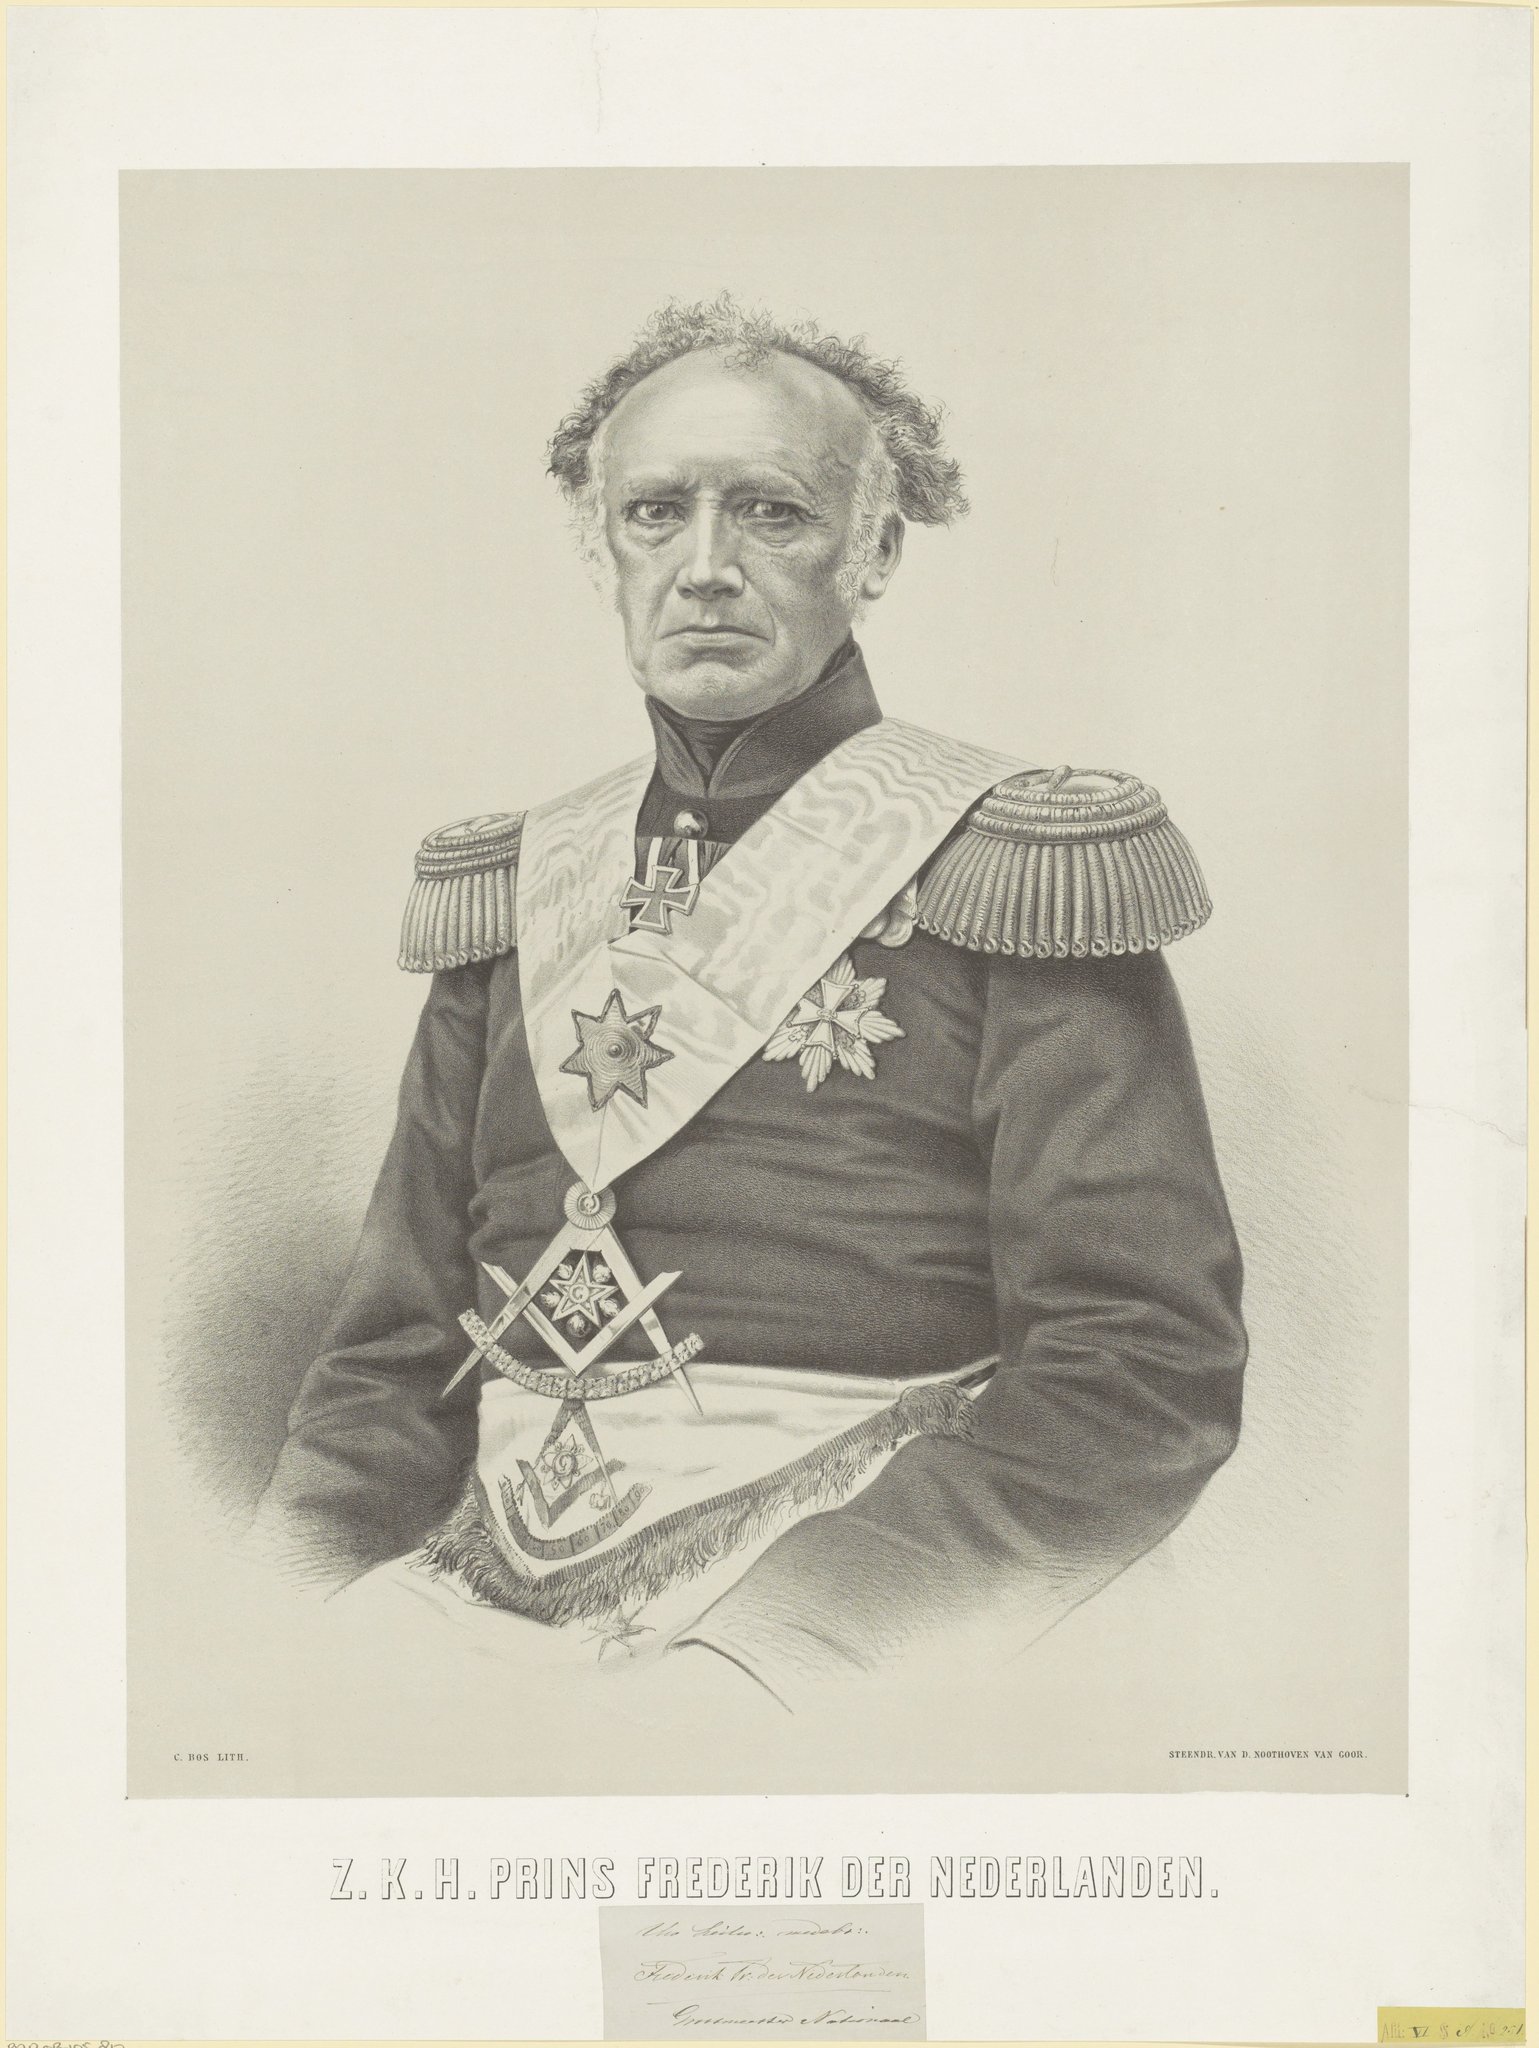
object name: print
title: Portret van Frederik, prins der Nederlanden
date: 1850-1895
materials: paper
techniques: tone lithography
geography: netherlands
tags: frederik (prins der nederlanden)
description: De hier vermelde titel verwijst naar de hoogst verkregen titel van de geportretteerde, niet per se naar de titel die de geportretteerde op deze voorstelling draagt.